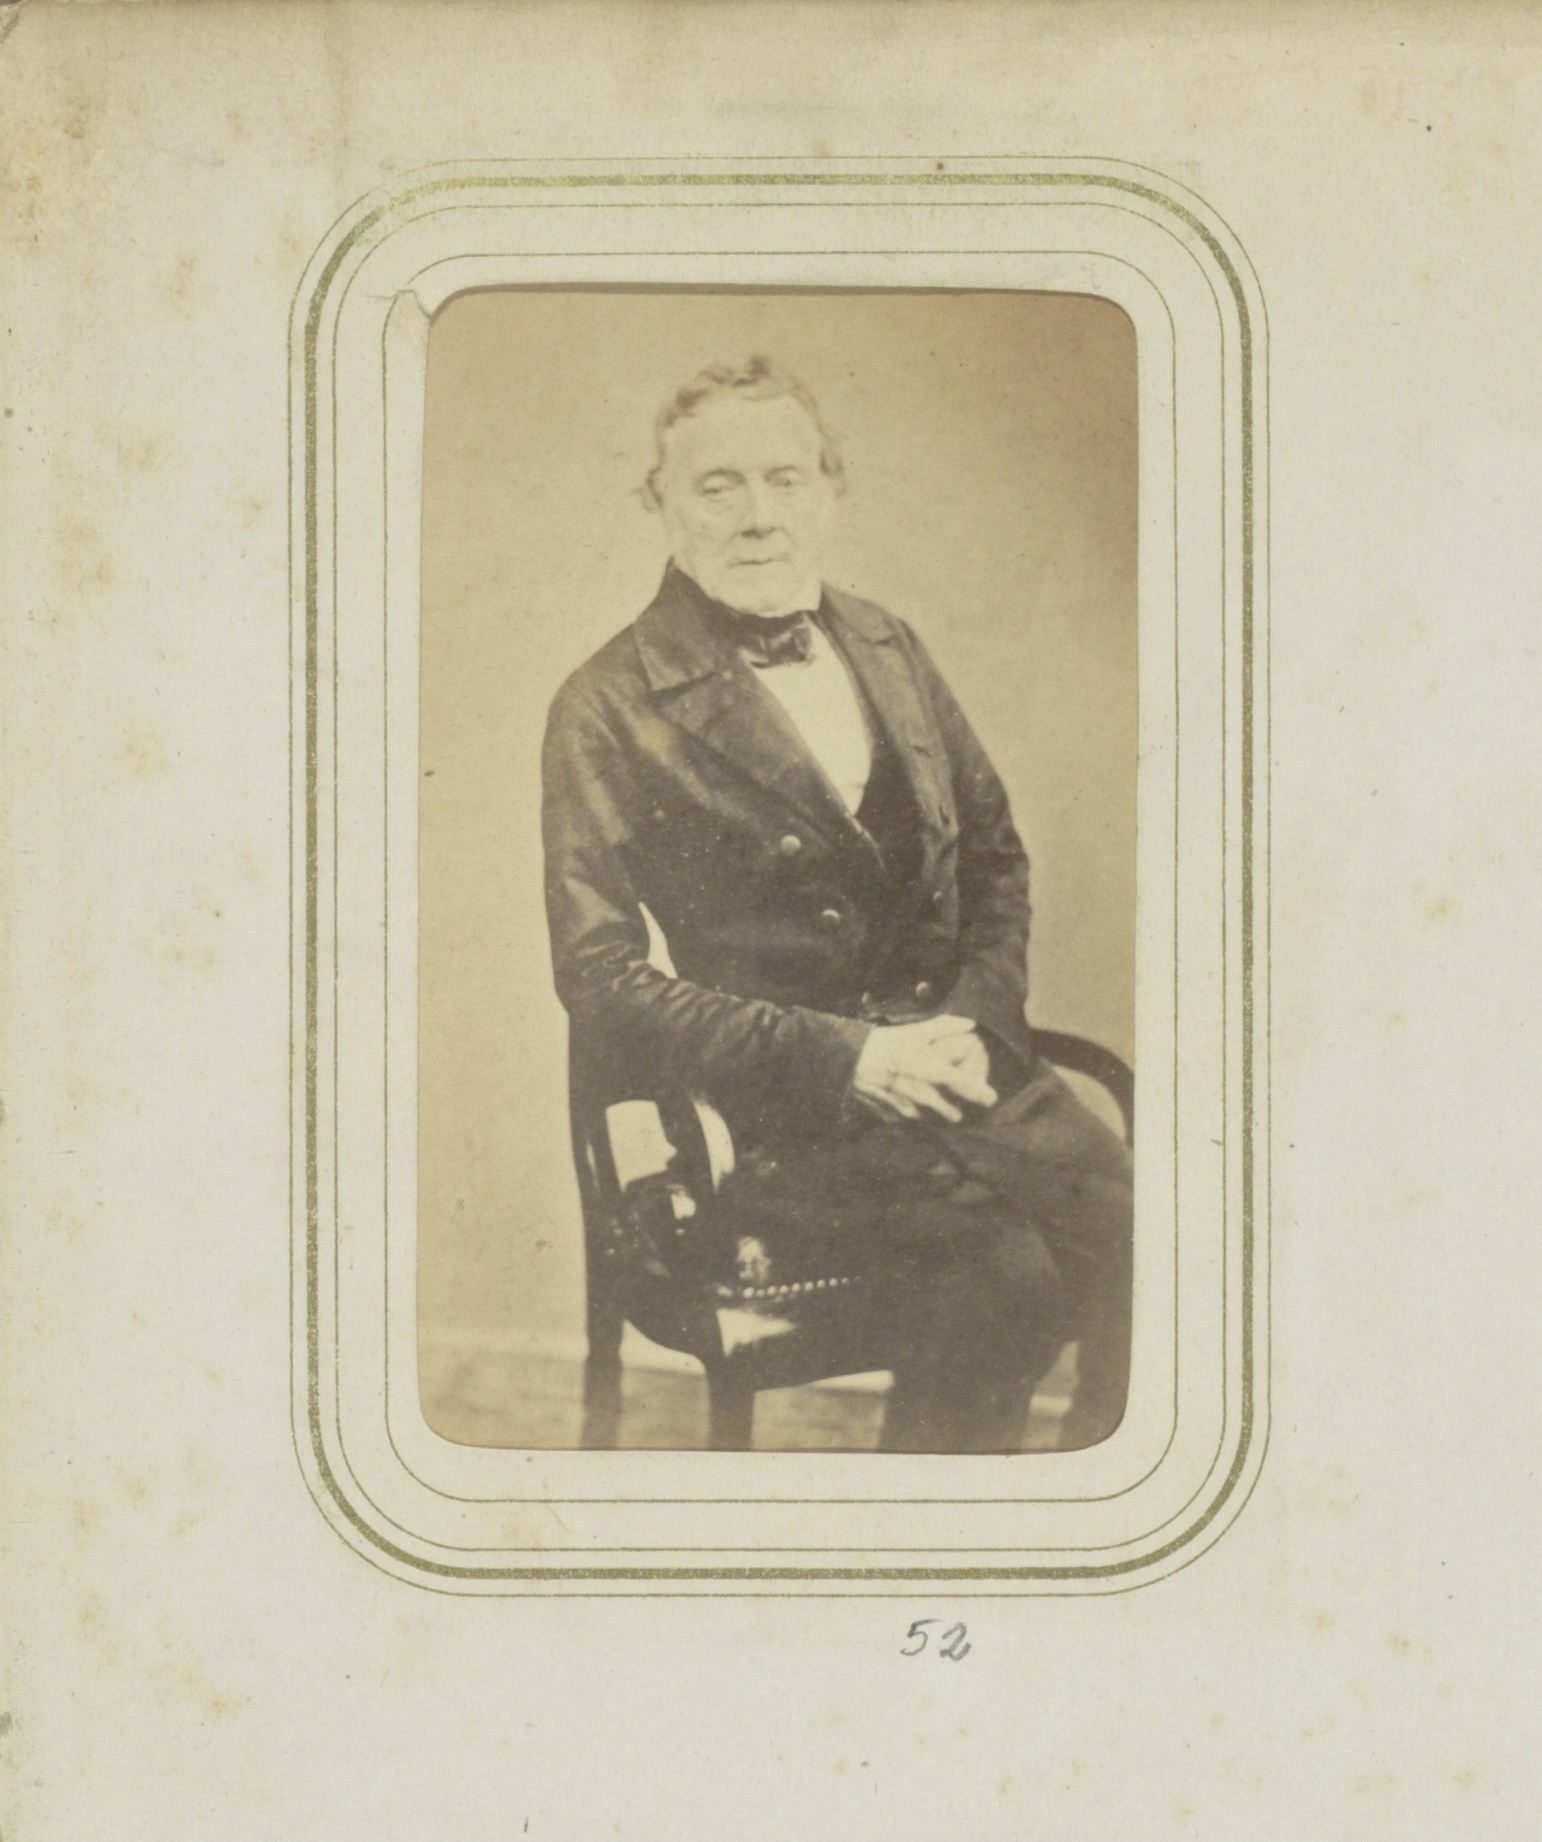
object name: carte de visite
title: Portret van een man in een jas met een strik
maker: wilhelm frederick antonius delboy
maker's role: fotograaf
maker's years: 1853-1928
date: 1864-1886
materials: cardboard, photographic support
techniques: albumen print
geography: the hague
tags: priest (roman catholic), trousers, breeches, historical persons, neck-gear ~ clothing, family, relationship, descent, hairdress, coat, cape, the hague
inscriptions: address: ‘Gortstraat, 'S Hage.’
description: Onderdeel van Familiealbum van H.W.F. Ligtenberg en L.M. Swart met 149 foto's en cartes-de-visite.